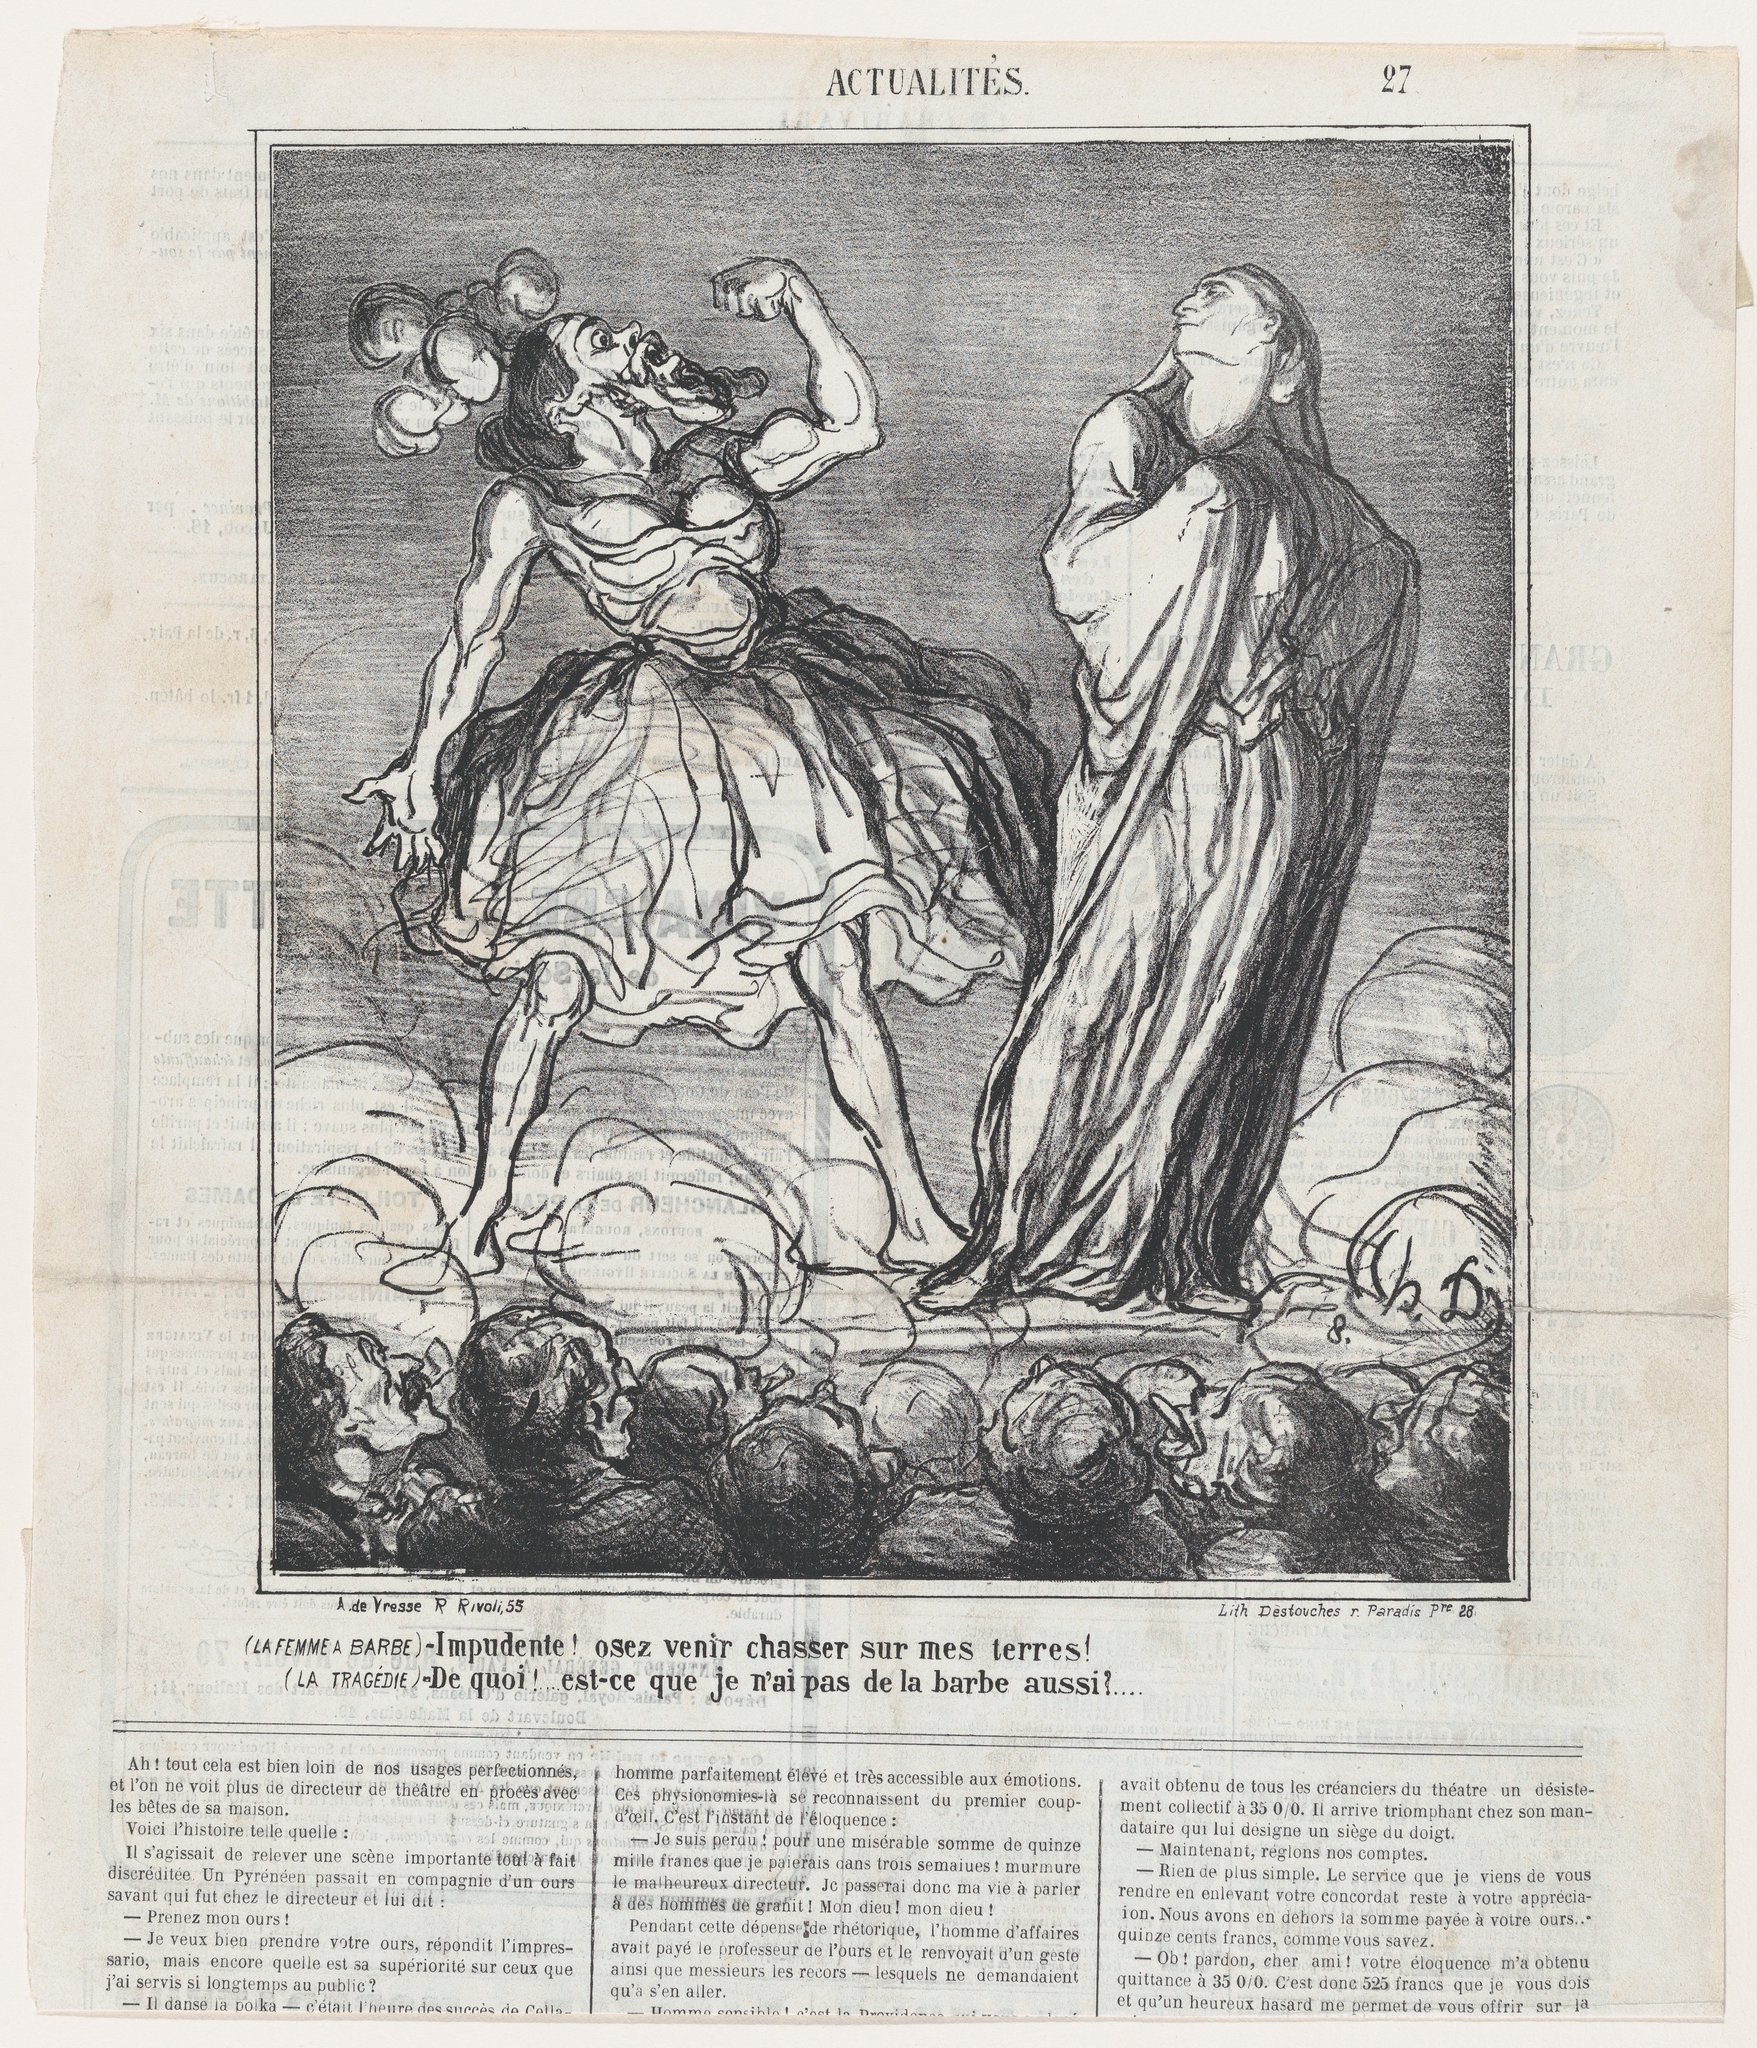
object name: print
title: The bearded lady: Imprudent woman! You dare hunt on my territory! Tragedy: What! Don't I have a beard as well?, from 'News of the day,' published in Le Charivari, February 16, 1867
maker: honoré daumier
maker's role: artist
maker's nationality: french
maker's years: 1808-1879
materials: paper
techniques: lithograph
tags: performance,women,spectators,actors